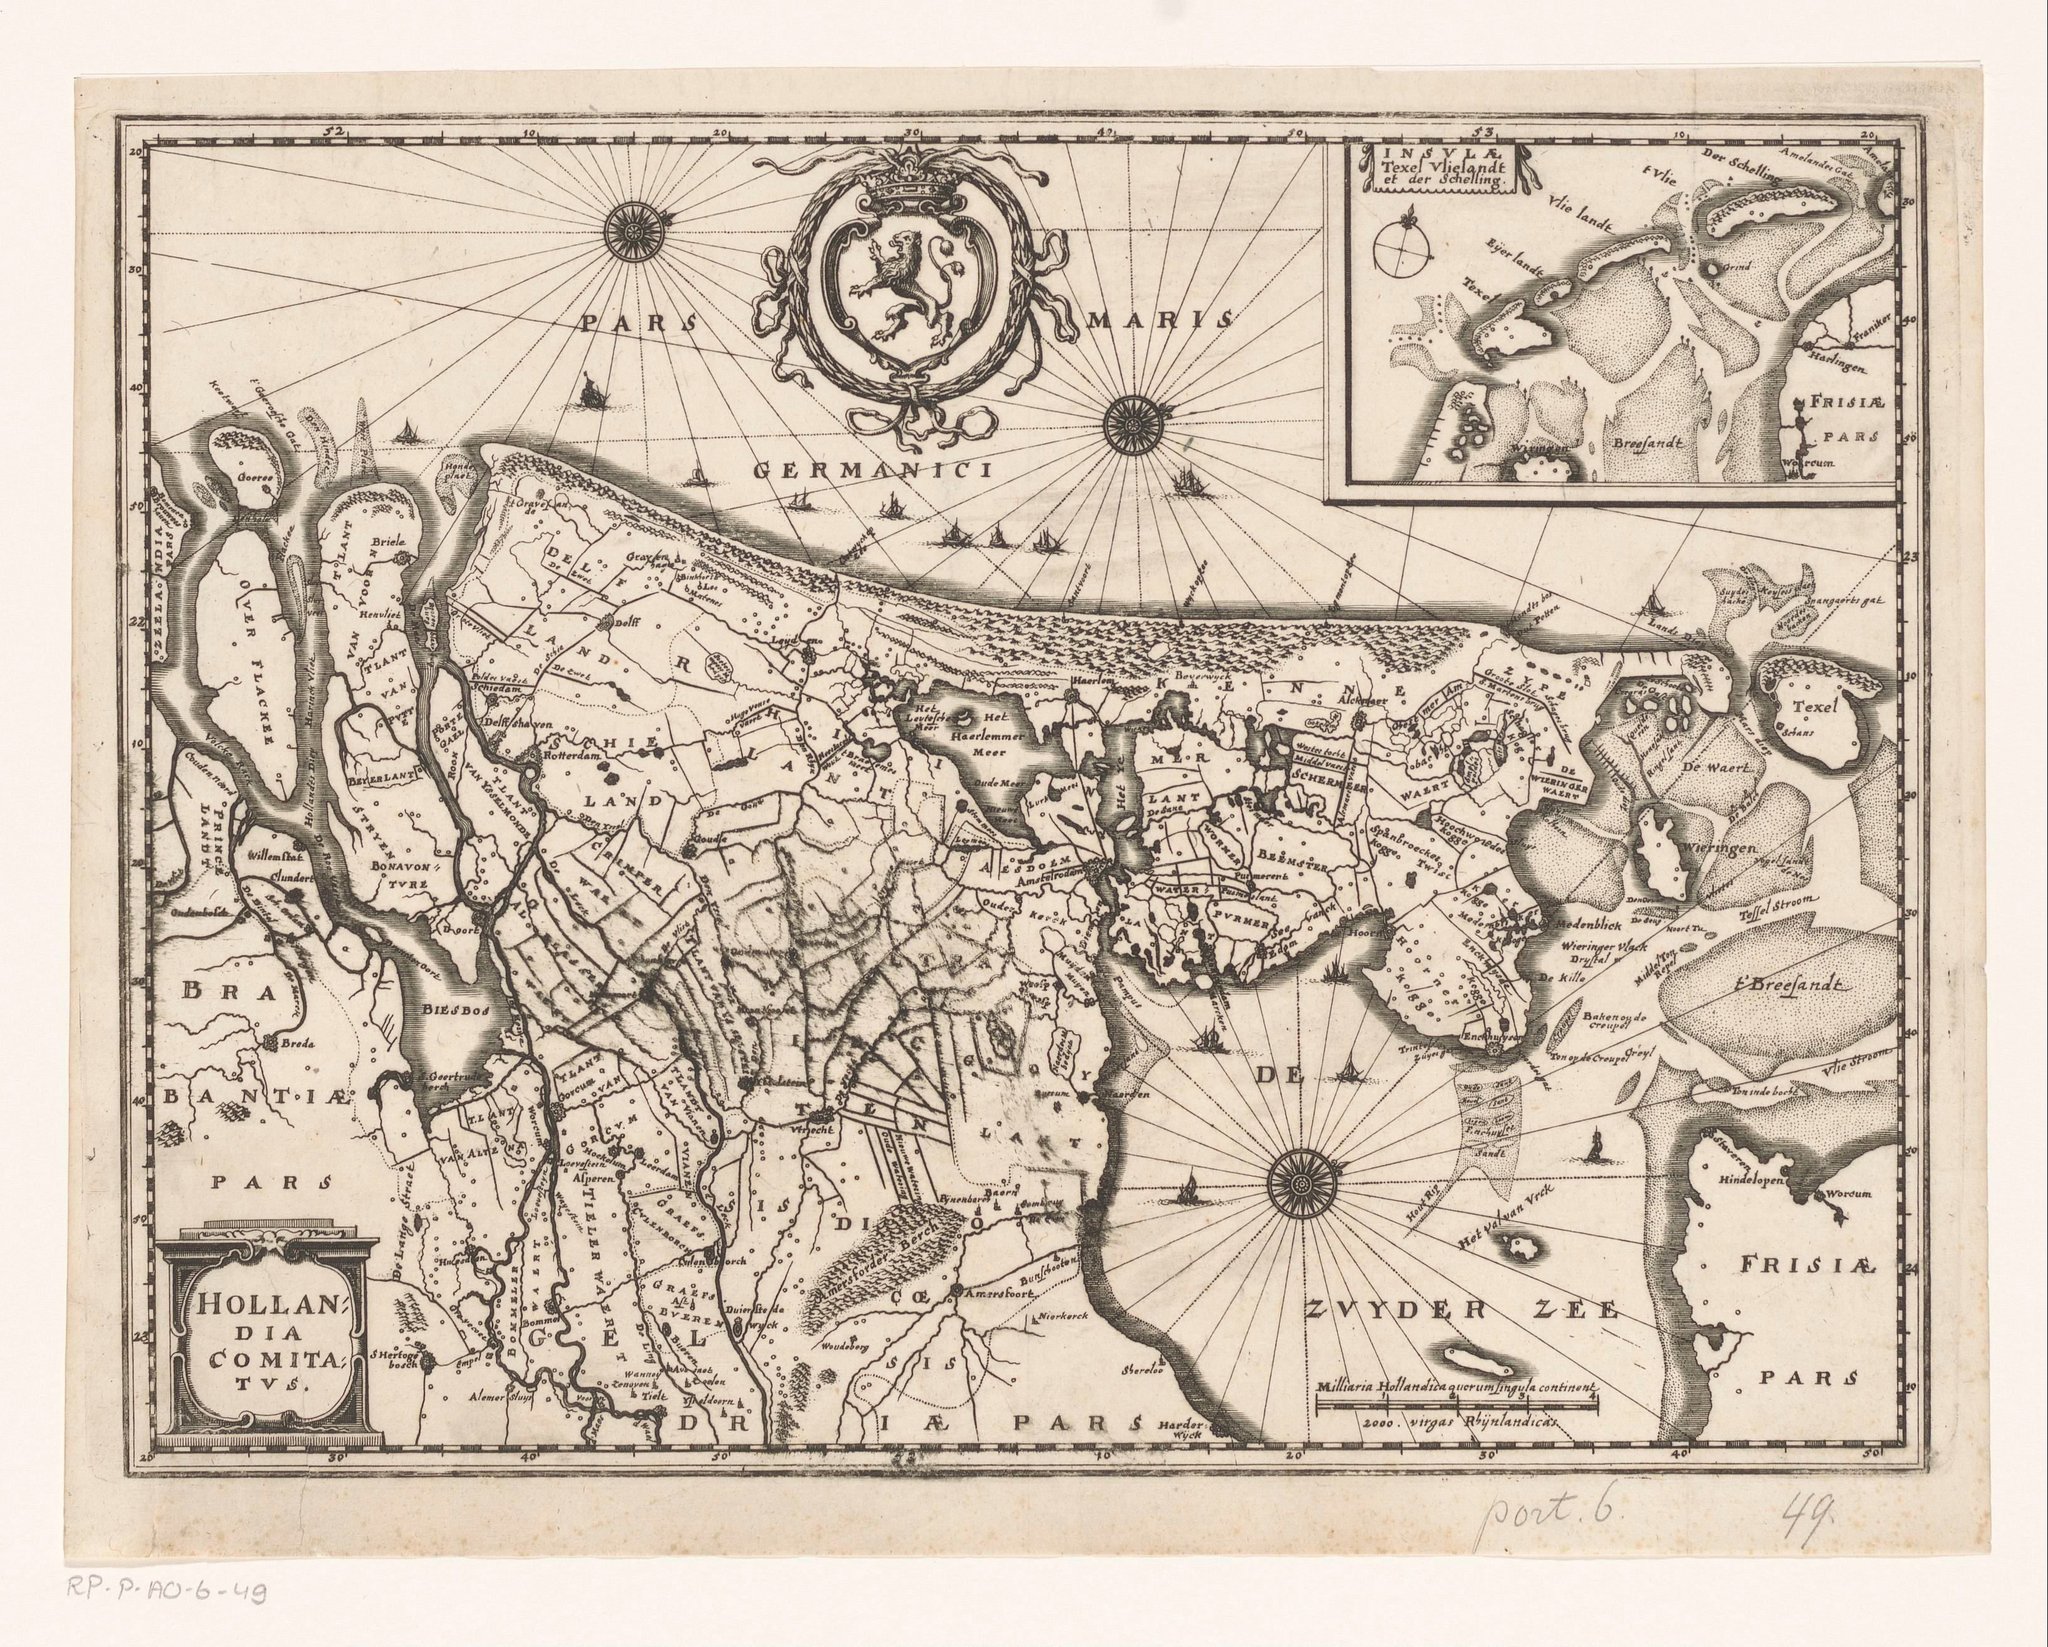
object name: print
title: Kaart van het graafschap Holland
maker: caspar merian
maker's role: print maker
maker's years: 1627-1689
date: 1654-1700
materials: paper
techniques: engraving, etching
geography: frankfurt am main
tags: maps of separate countries or regions, holland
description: Prent gebruikt in: Zeiller, Martin. M.Z. Topographia Circuli Burgundici Oder Beschreibung une Eigentliche Abbildung der Vornehmsten Örter in dem Hochlöblichen Burgund- un Niderlandischen Crayse. Frankfurt am Main: Caspar Merian, 1654. Of in: Zeiller, Martin. M. Z. Topographia Germaniae-Inferioris vel Circuli-Burgundici, das ist Beschreibung (…). Frankfurt am Main: Caspar Merian, 1659. Of in een van de twee latere uitgaven van deze publicatie die, hoewel het jaar 1659 erin staat vermeld als jaar van uitgave, zijn uitgegeven in respectievelijk ca. 1670 en ca. 1700.